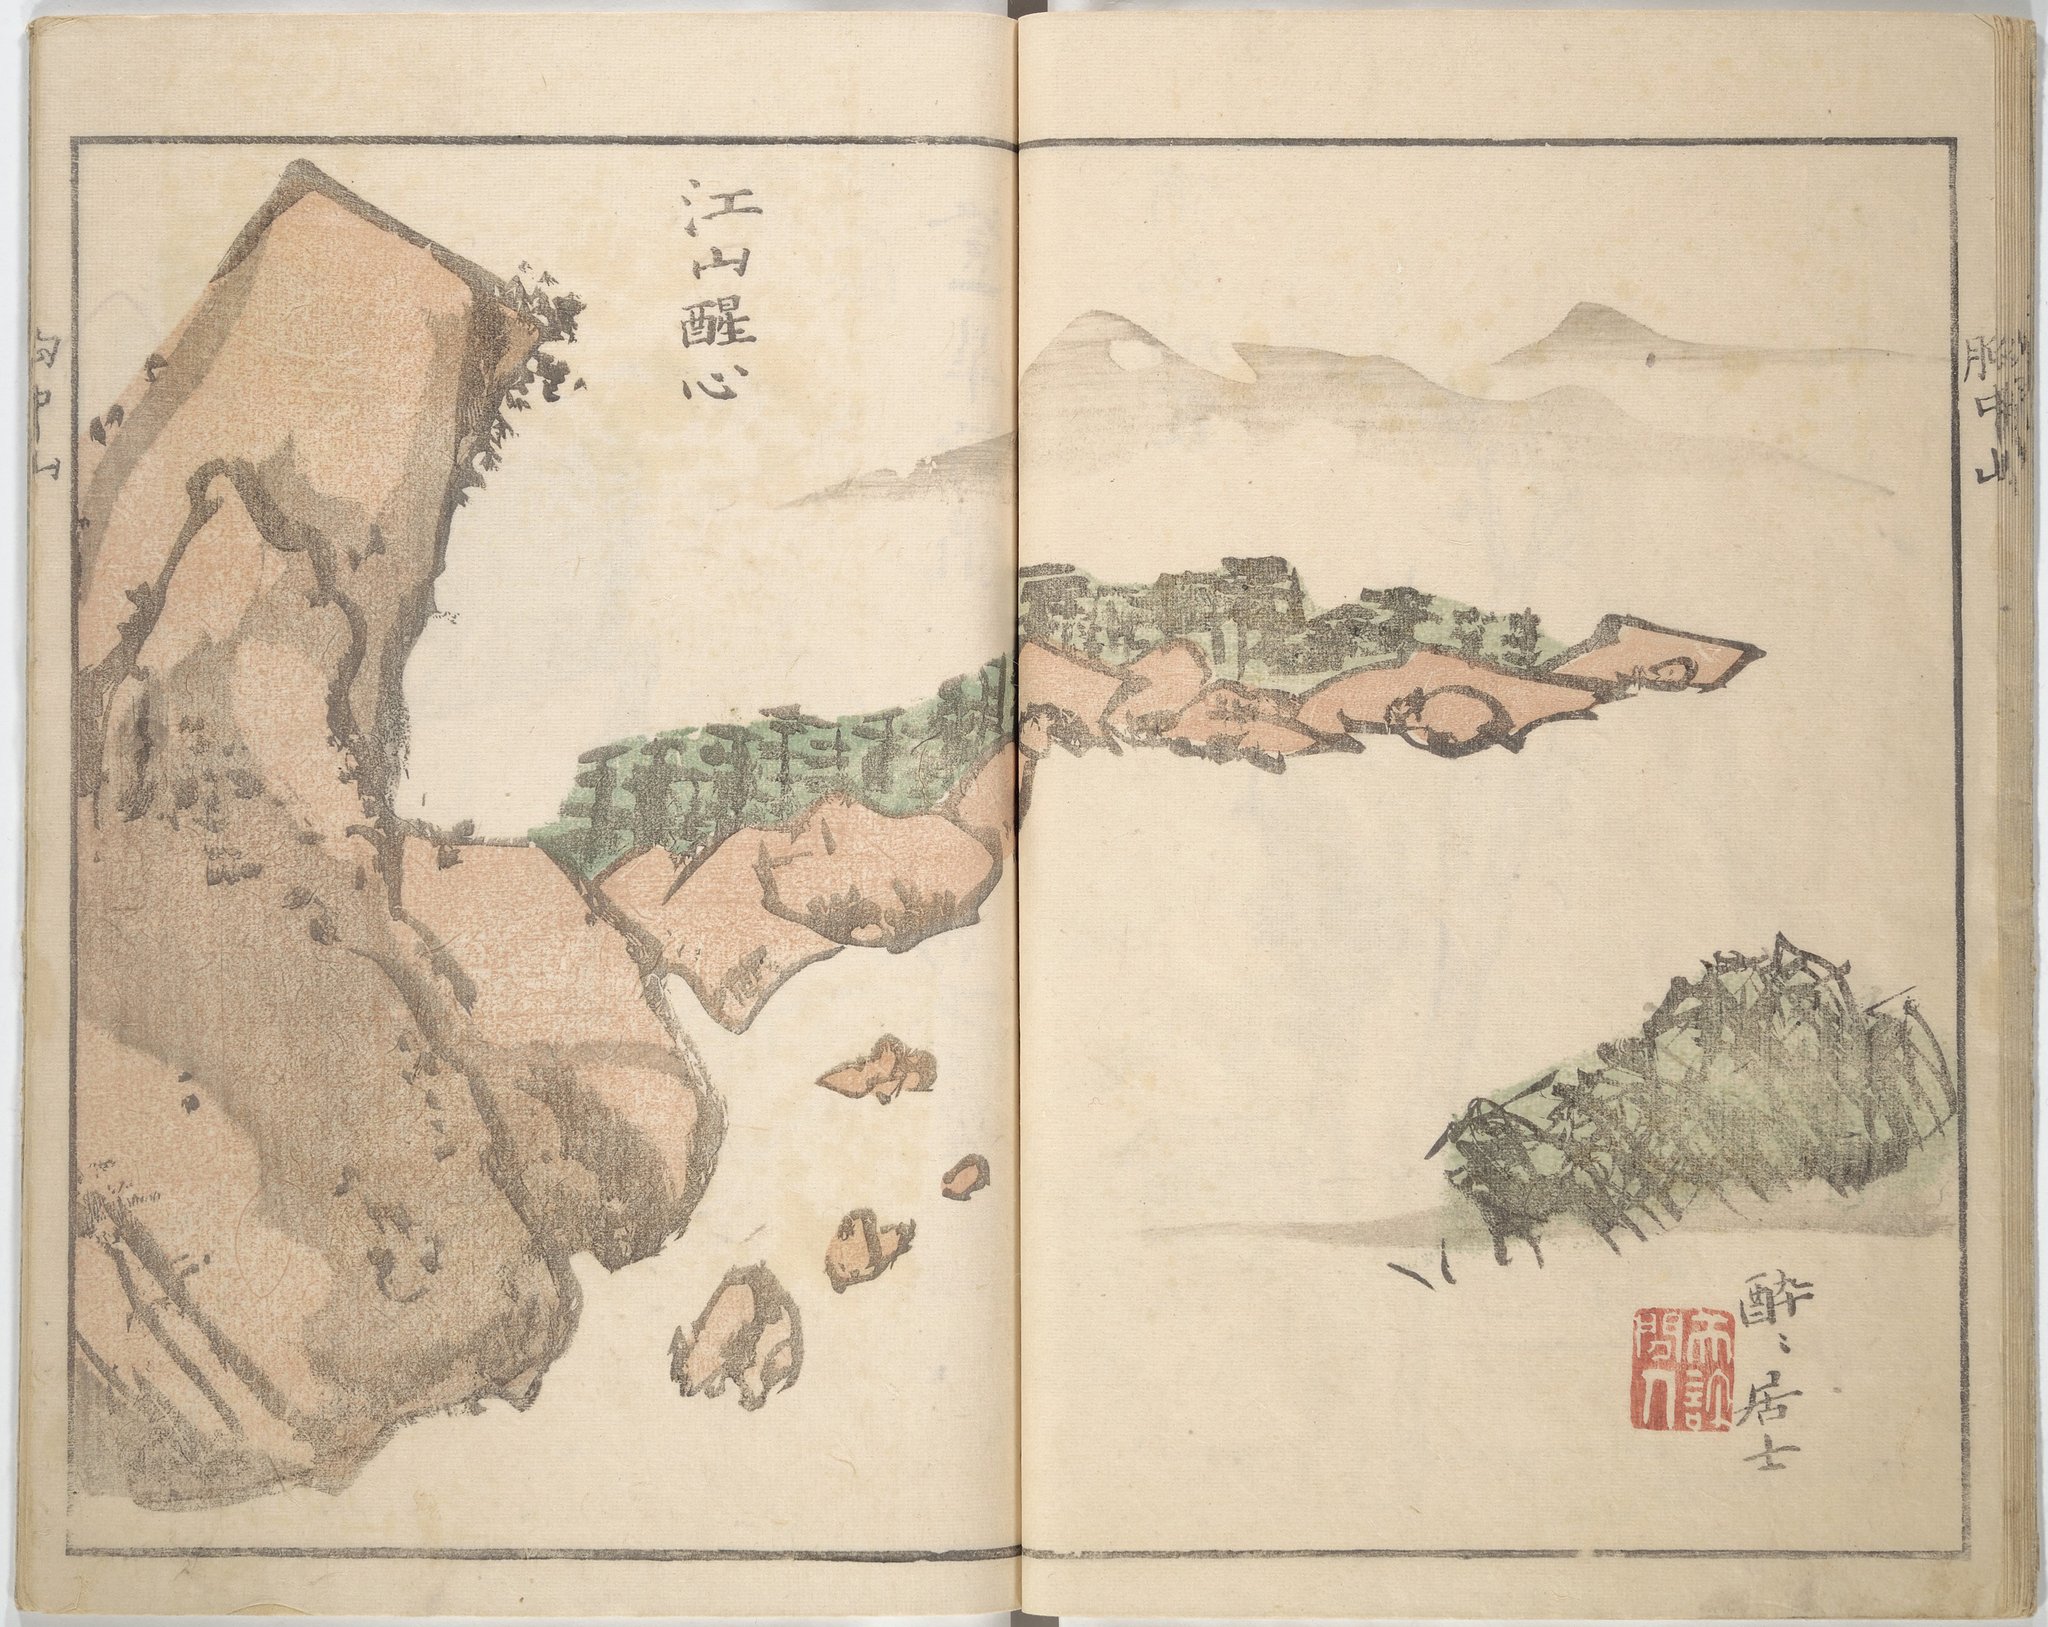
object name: illustrated book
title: Mountains of the Heart (Kyōchūzan)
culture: japanese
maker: kameda bōsai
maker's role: artist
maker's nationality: japanese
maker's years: 1752-1826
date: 1816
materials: ink, paper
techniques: woodblock print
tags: mountains